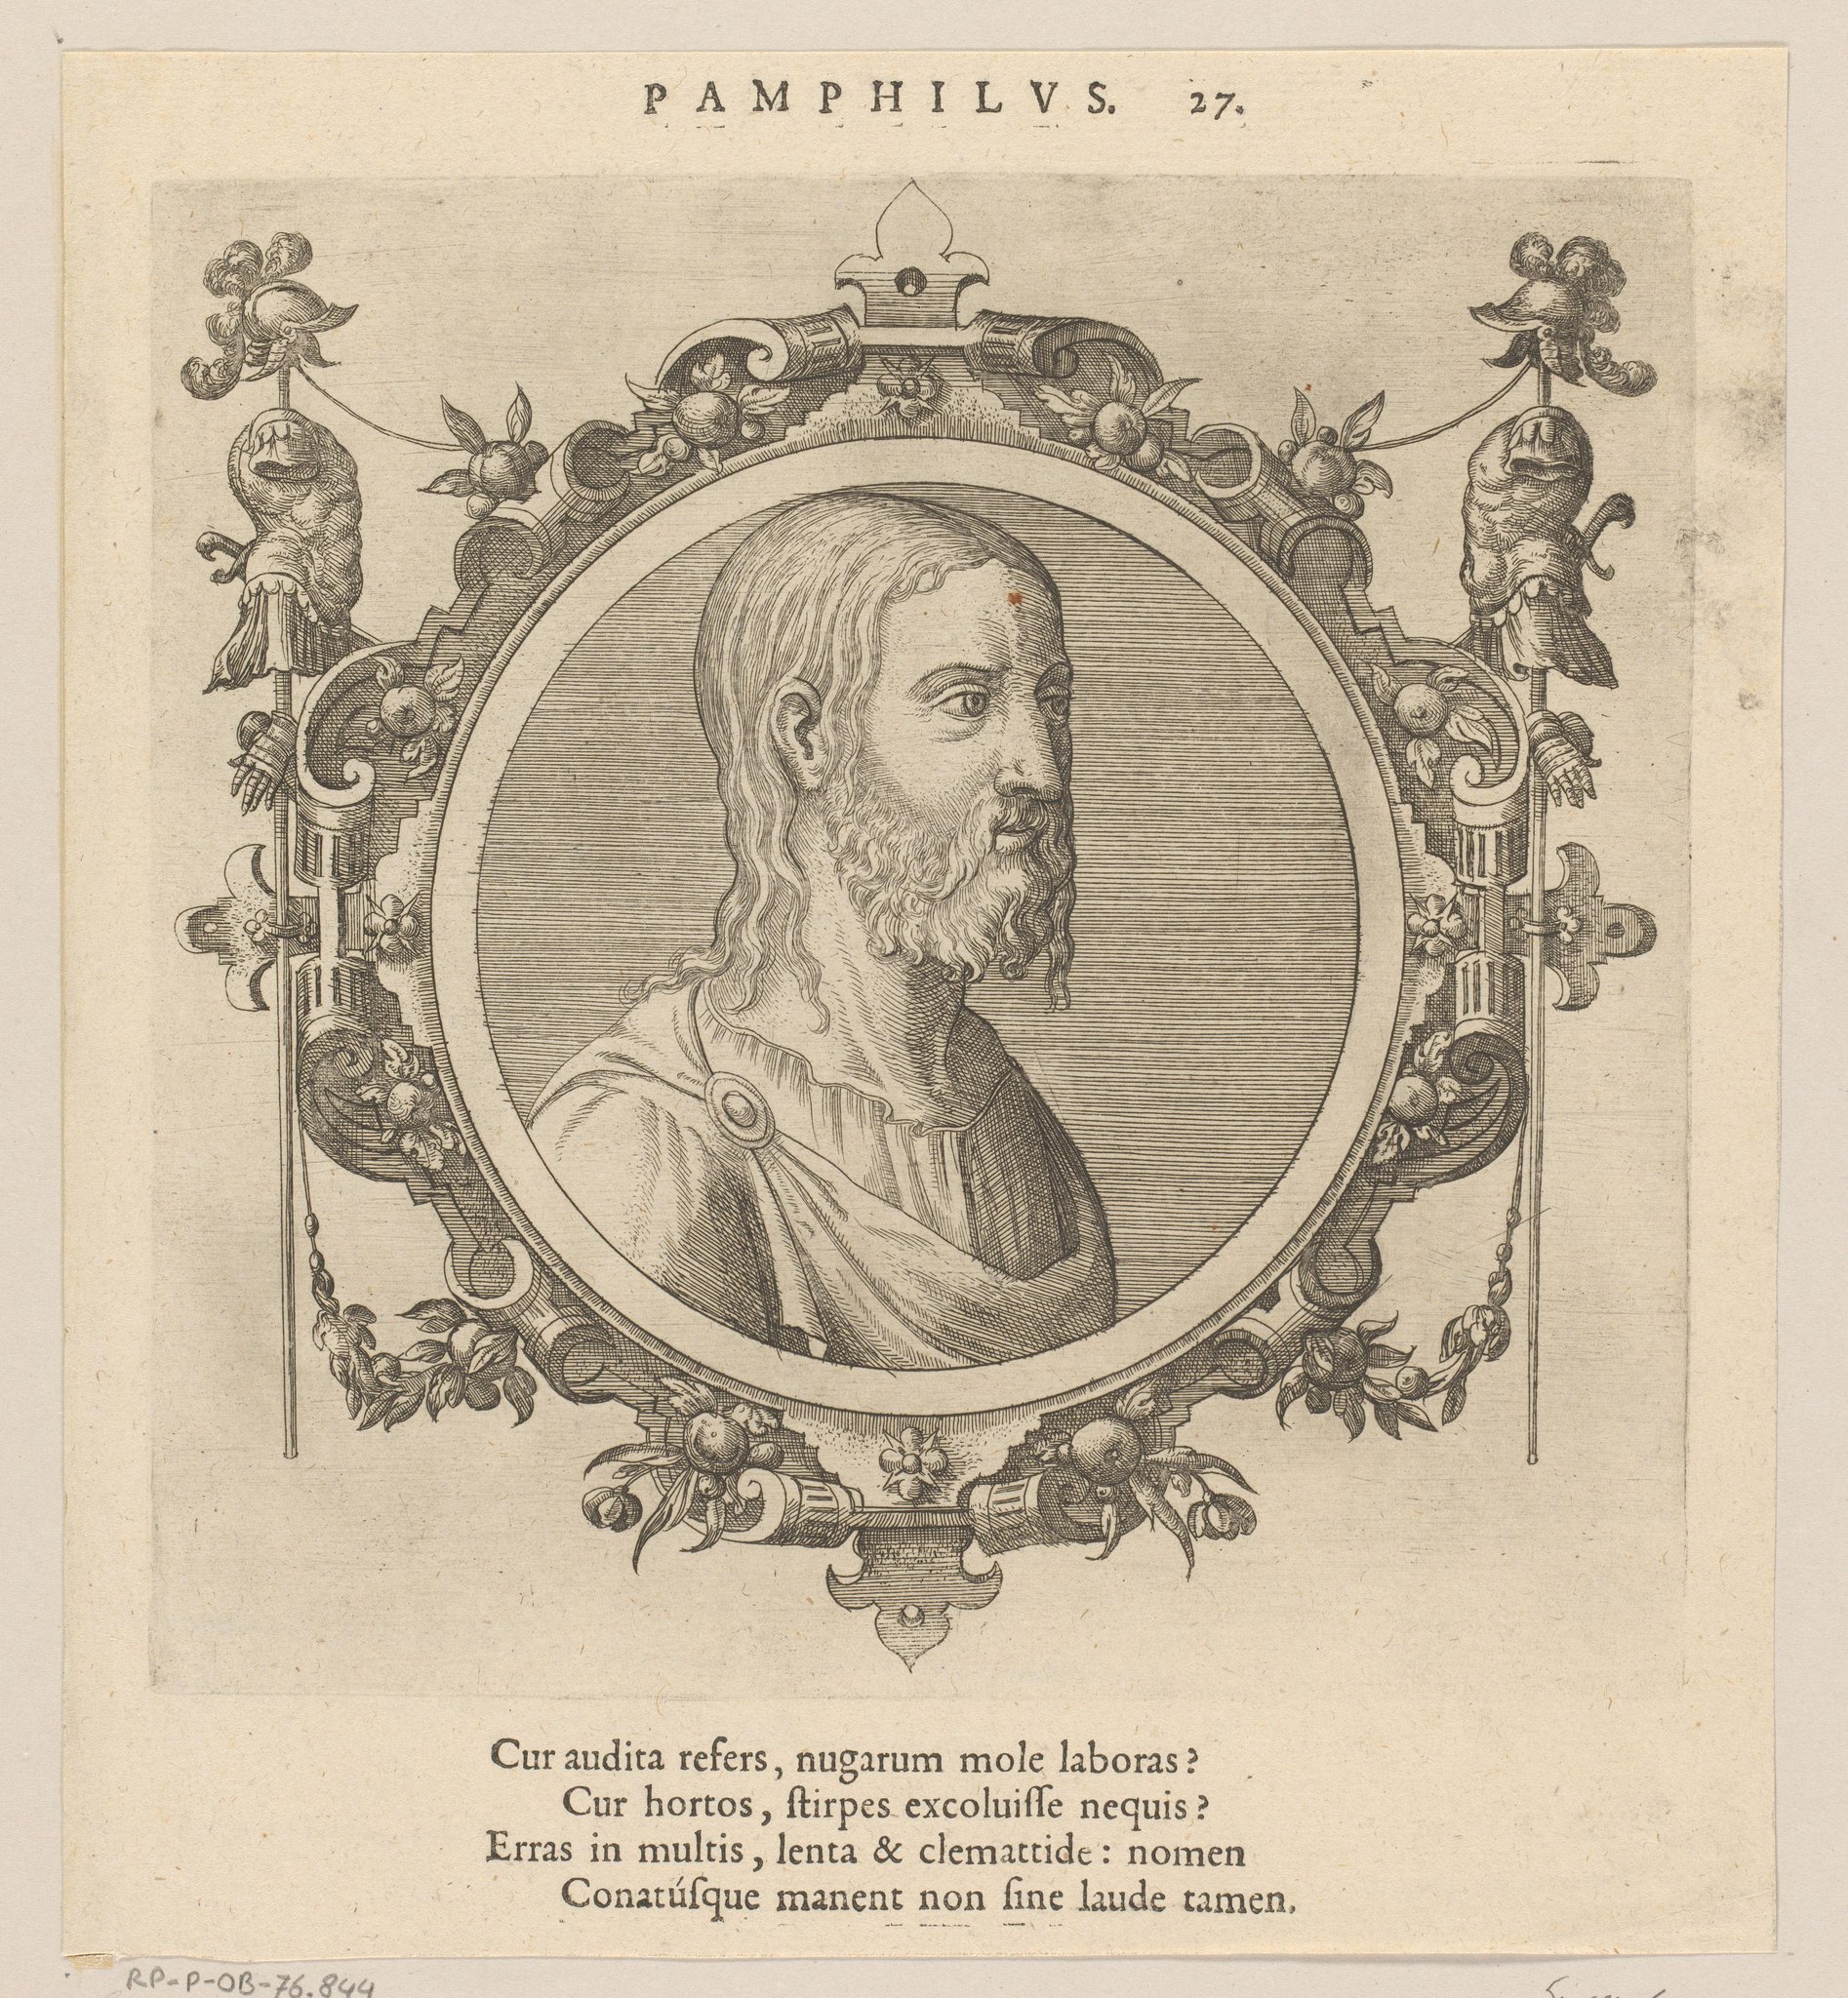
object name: print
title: Portret van filosoof Pamphilius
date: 1574-1612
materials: paper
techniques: etching, letterpress printing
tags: scrollwork, strapwork ~ ornament, scholar, philosopher, historical persons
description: Portretbuste in ronde ornamentale omlijsting.